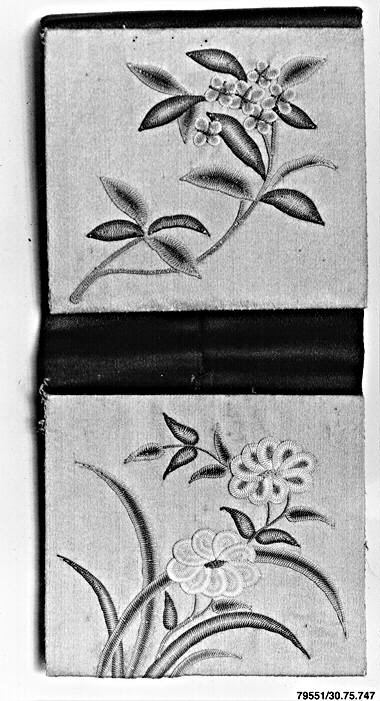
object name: bag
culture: chinese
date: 1701-1900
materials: silk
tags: flowers